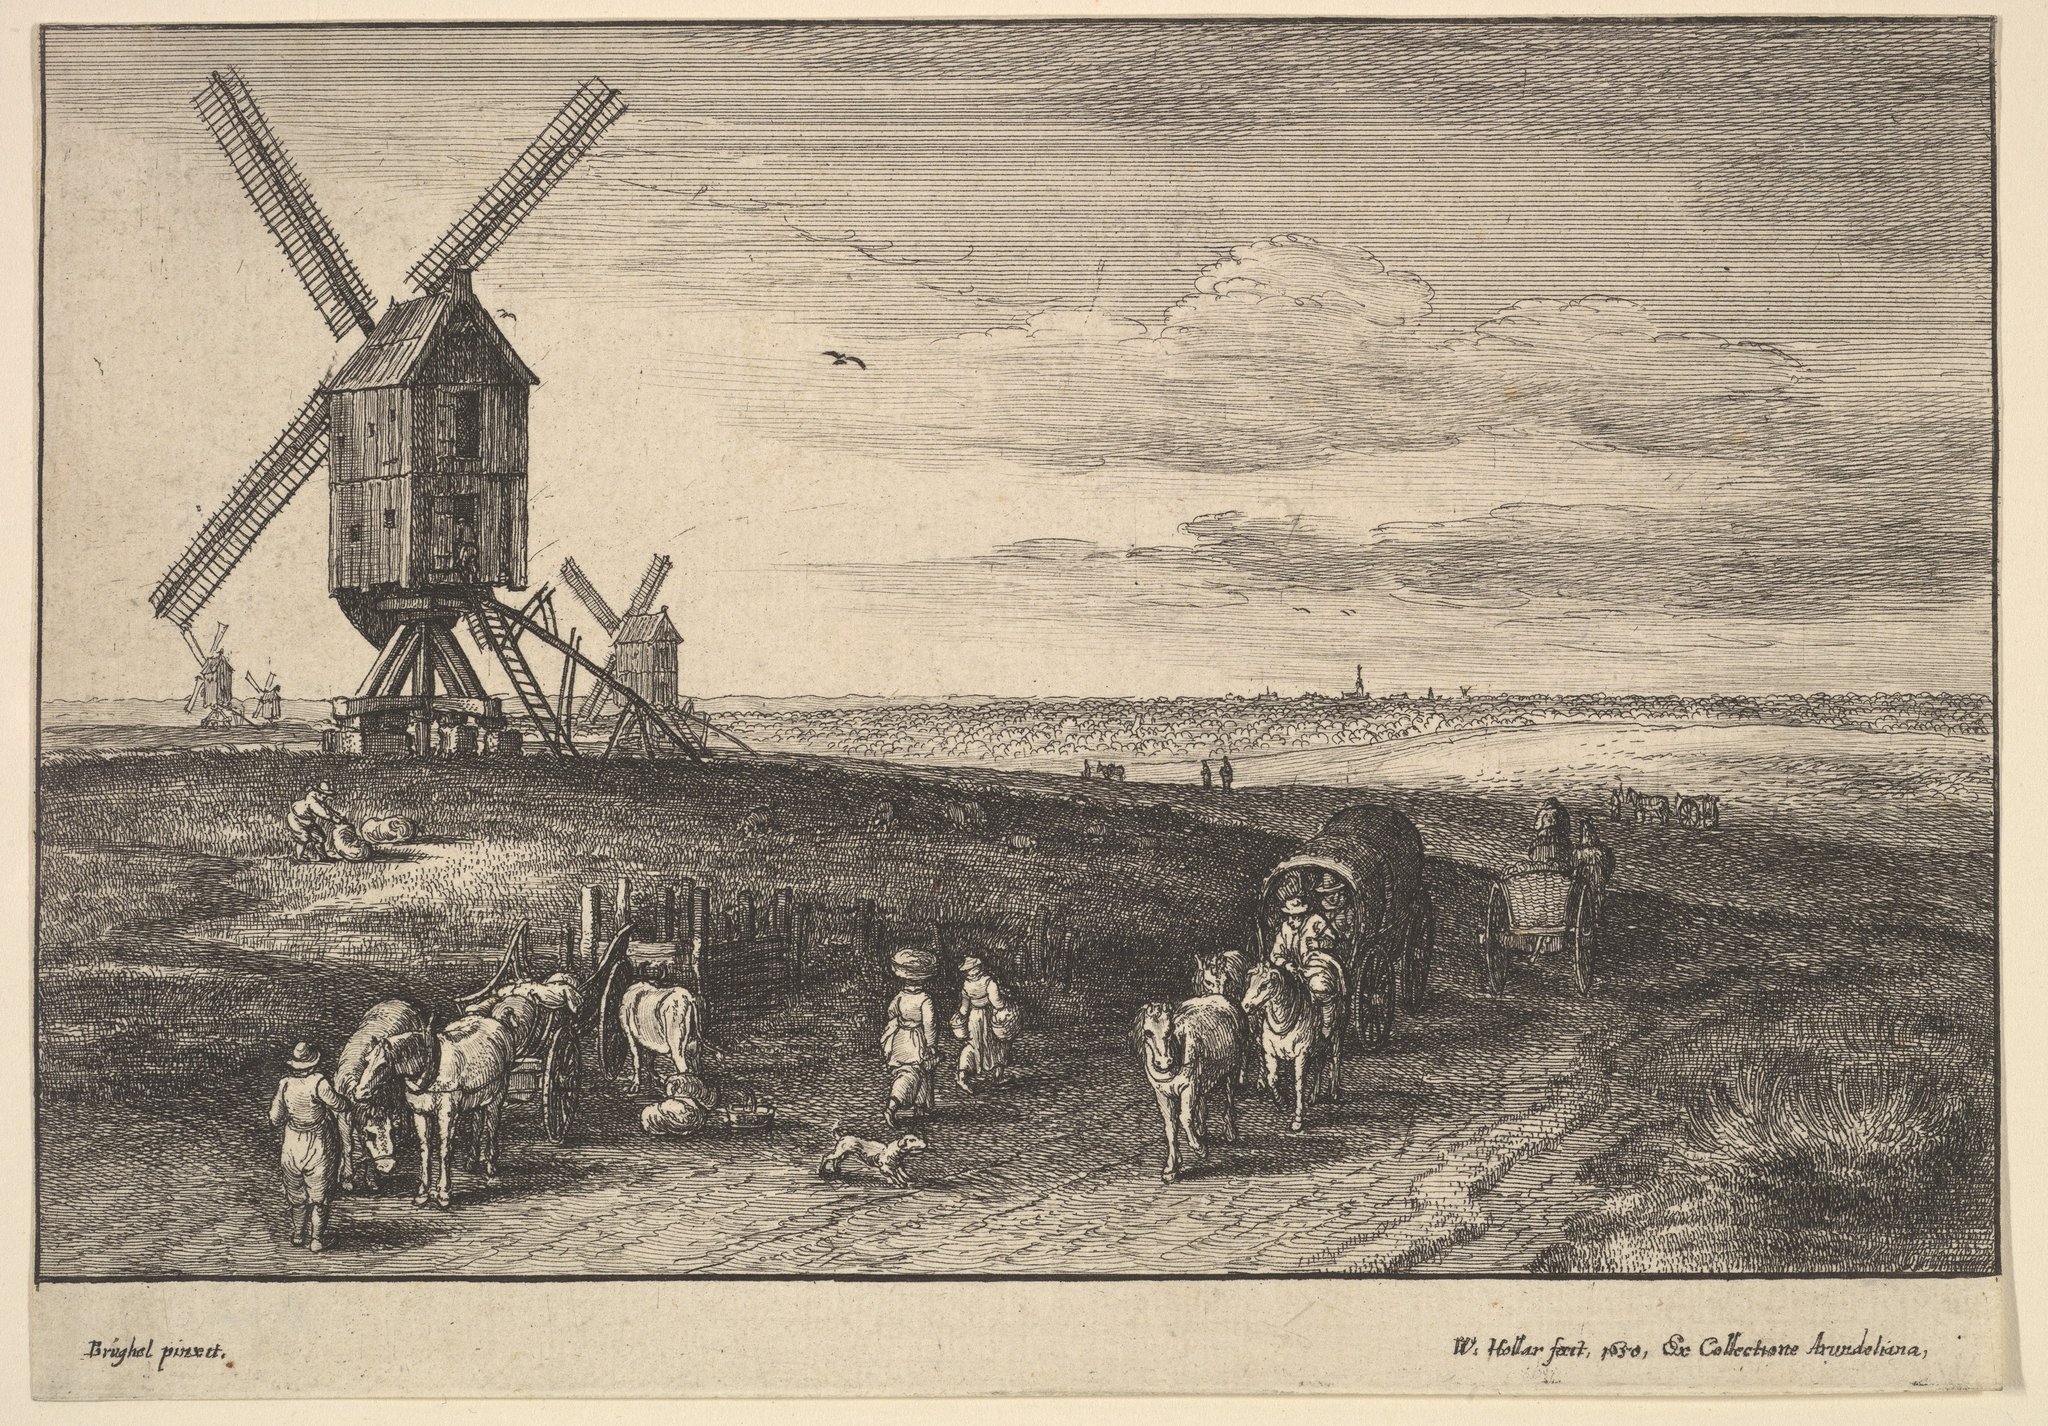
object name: print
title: The Four Windmills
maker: wenceslaus hollar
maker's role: artist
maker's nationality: bohemian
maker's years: 1607-1677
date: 1650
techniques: etching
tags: human figures,windmills,horses,carriages